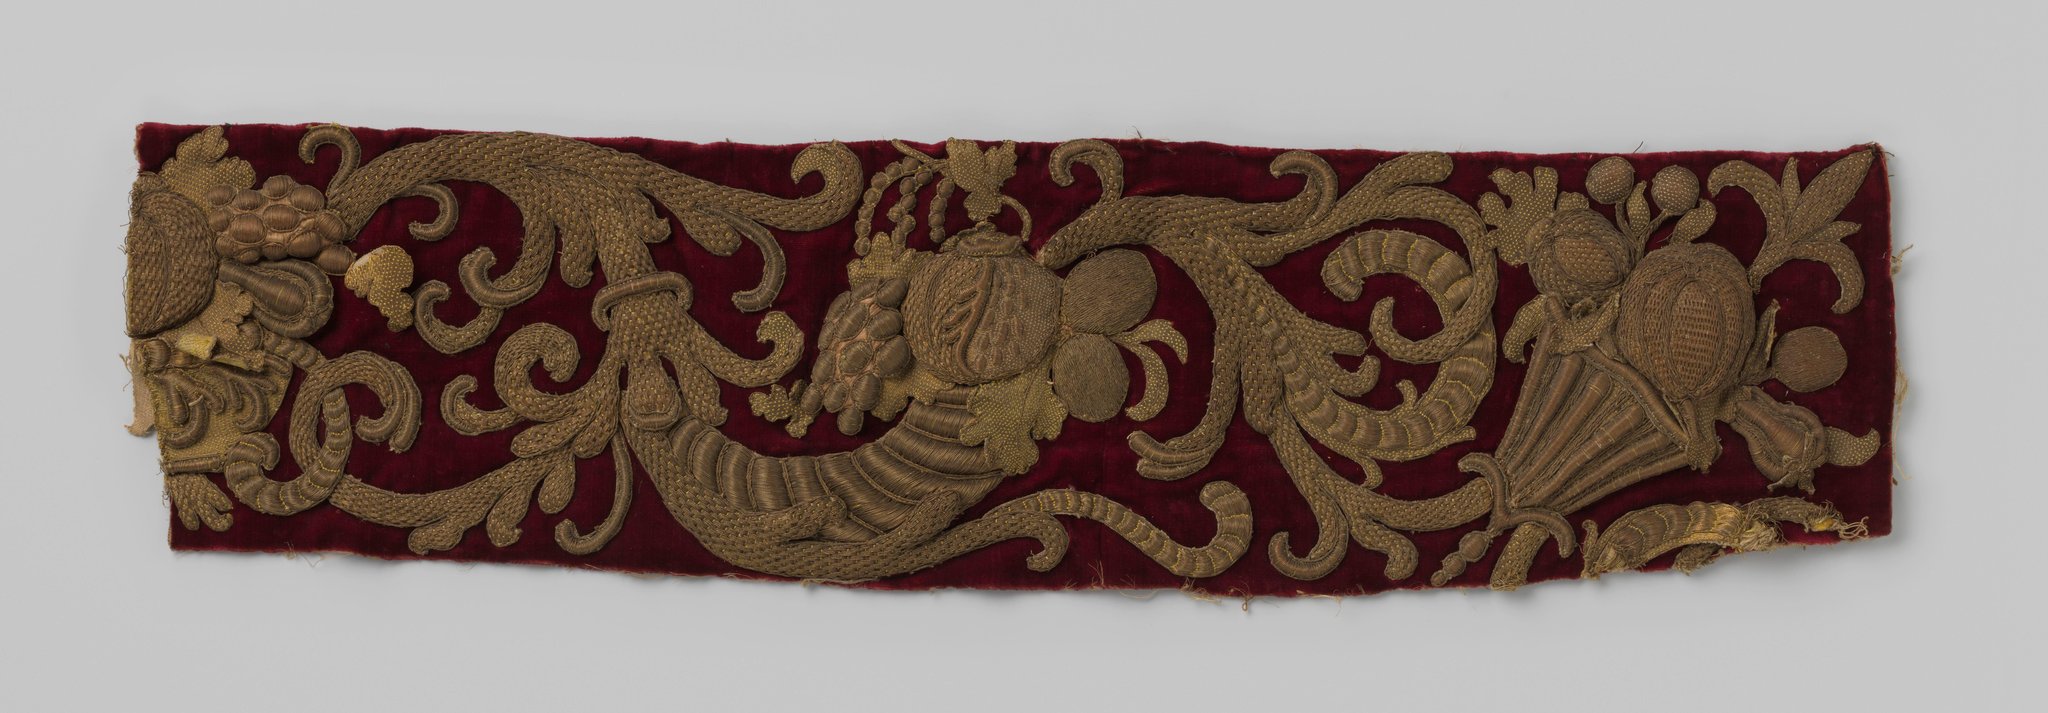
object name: strip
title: Strook borduurwerk.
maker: Anonymous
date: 1700-1725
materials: gold thread, velvet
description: Strook met gouden borduurwerk op karmozijnrode, fluwelen grond.